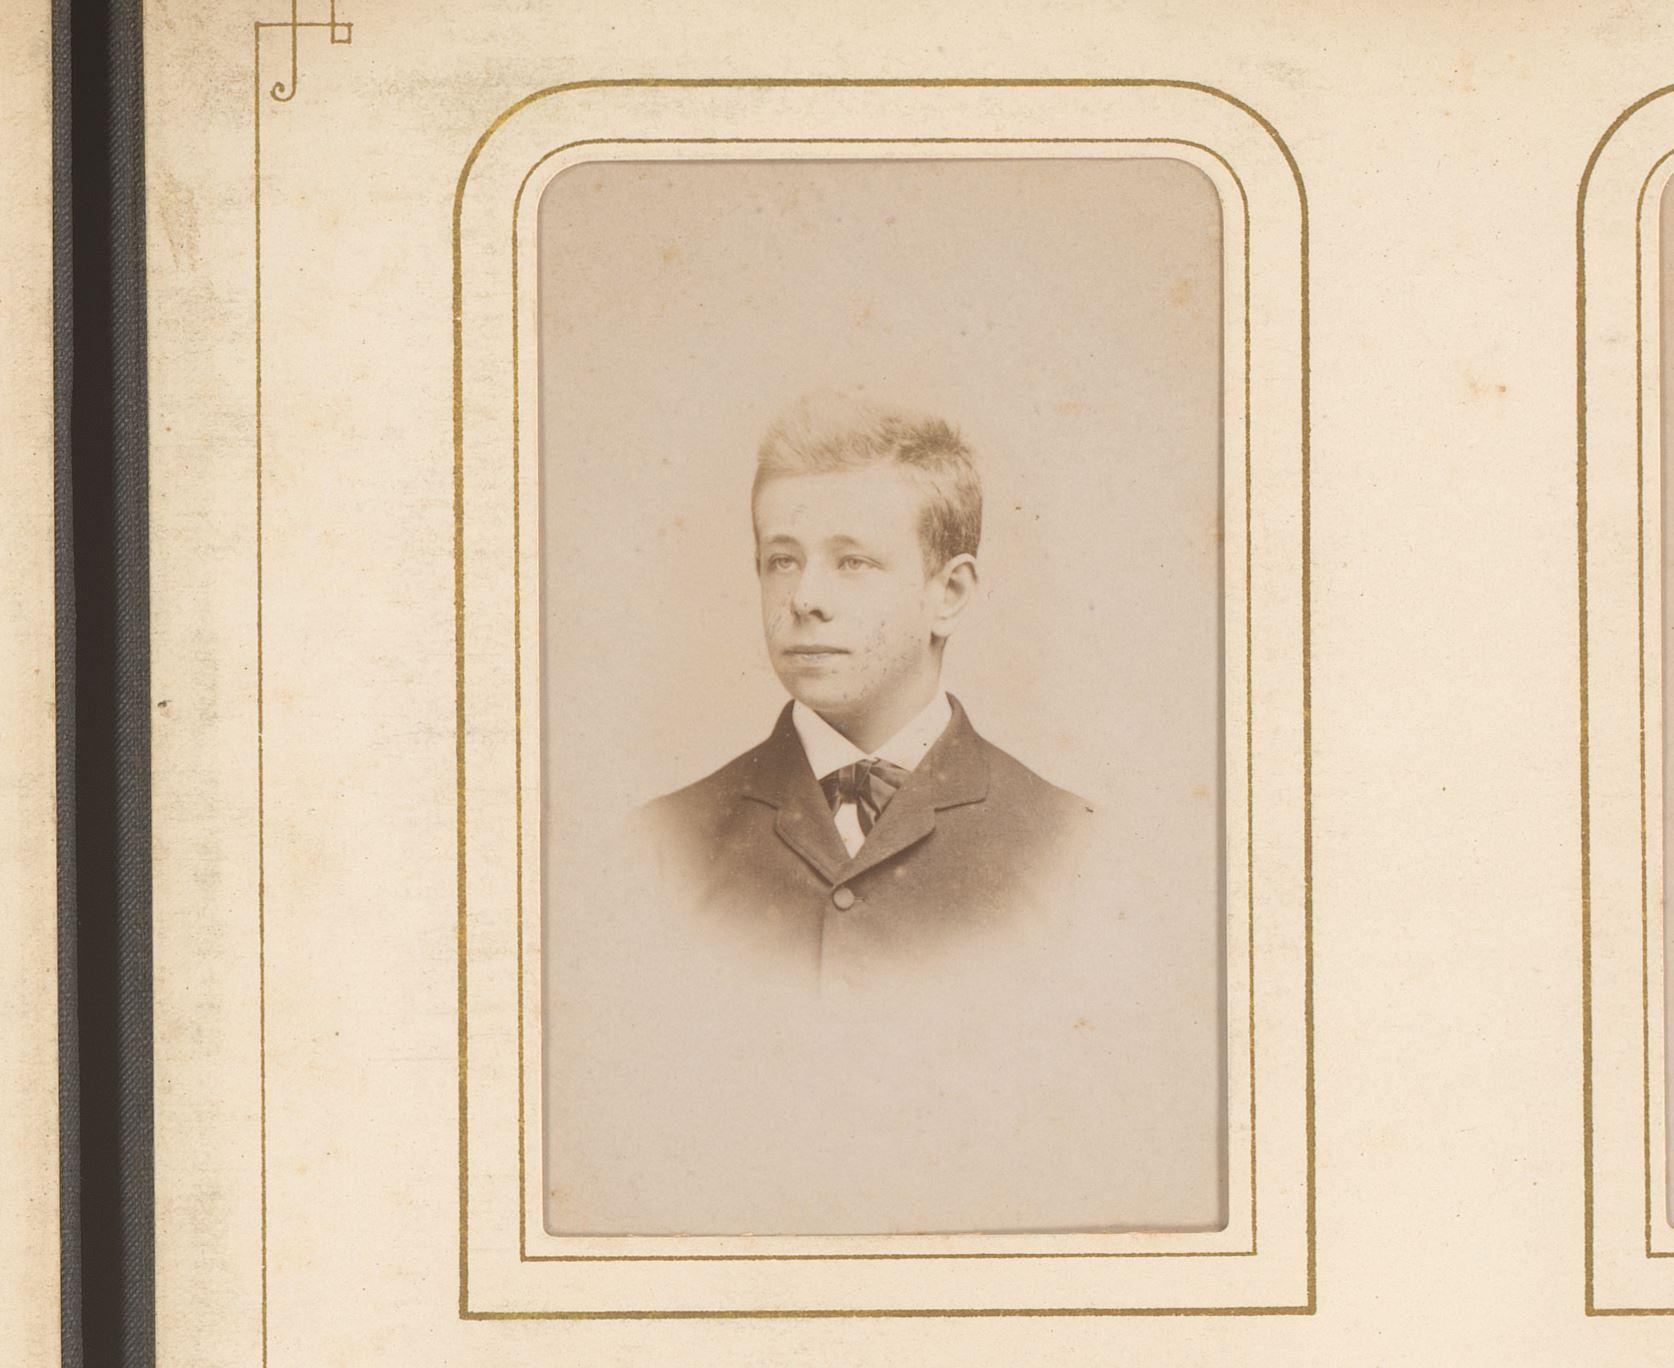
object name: album leaf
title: Portret van een jongen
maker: eugene guérin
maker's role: fotograaf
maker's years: 1845-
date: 1878-1885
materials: cardboard, photographic support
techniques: albumen print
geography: brussels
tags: boy (child between toddler and youth), historical persons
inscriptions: inscription: ‘MÉDAILLE D'OR NAPLES 1874/ MENTION HONORABLE EXPon UNIVle PARIS 1878/ Eugène Guérin/ 142, Rue Royale, 142/ Bruxelles’